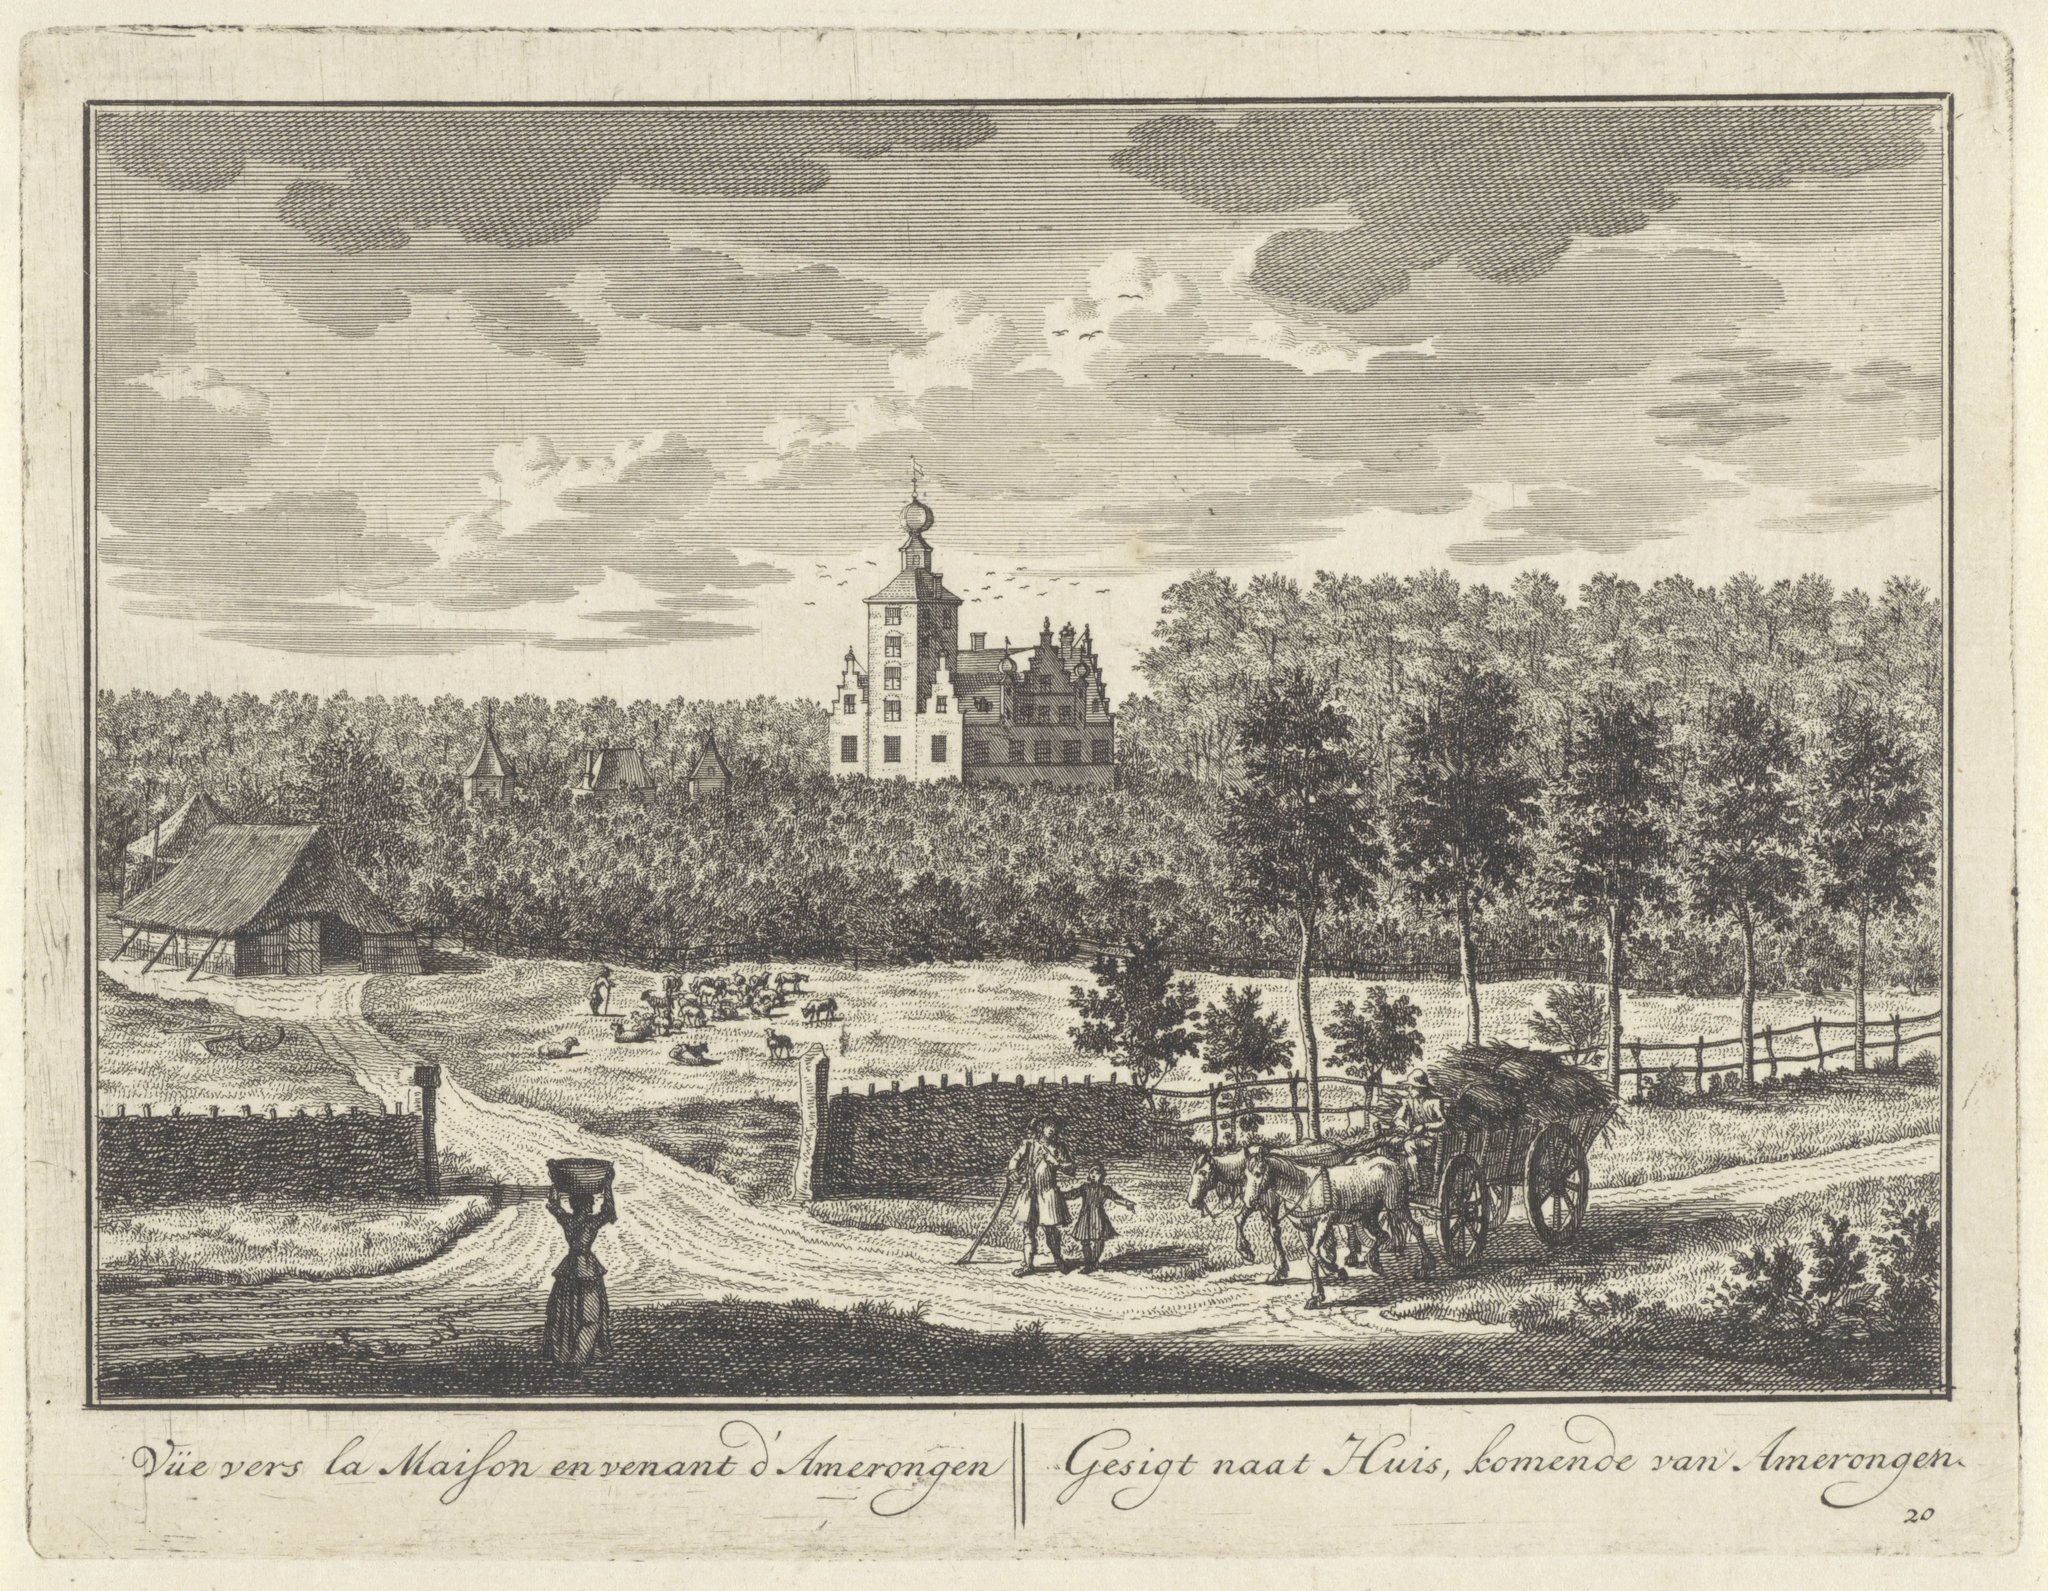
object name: print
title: Gesigt naat Huis, komende van Amerongen / Vüe vers la Maison en venant d'Amerongen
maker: daniël stopendaal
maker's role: print maker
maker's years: 1672-1726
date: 1682-1726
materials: paper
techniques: etching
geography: amsterdam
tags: castle, rural housing, e.g. country-house, villa, cottage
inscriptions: collector's mark: Lugt 2228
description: Gezicht vanaf de weg vanaf Amerongen op kasteel Zuilenstein te Leersum. Links een herder met zijn kudde. Op de voorgrond wandelaars en een kar getrokken door paarden.